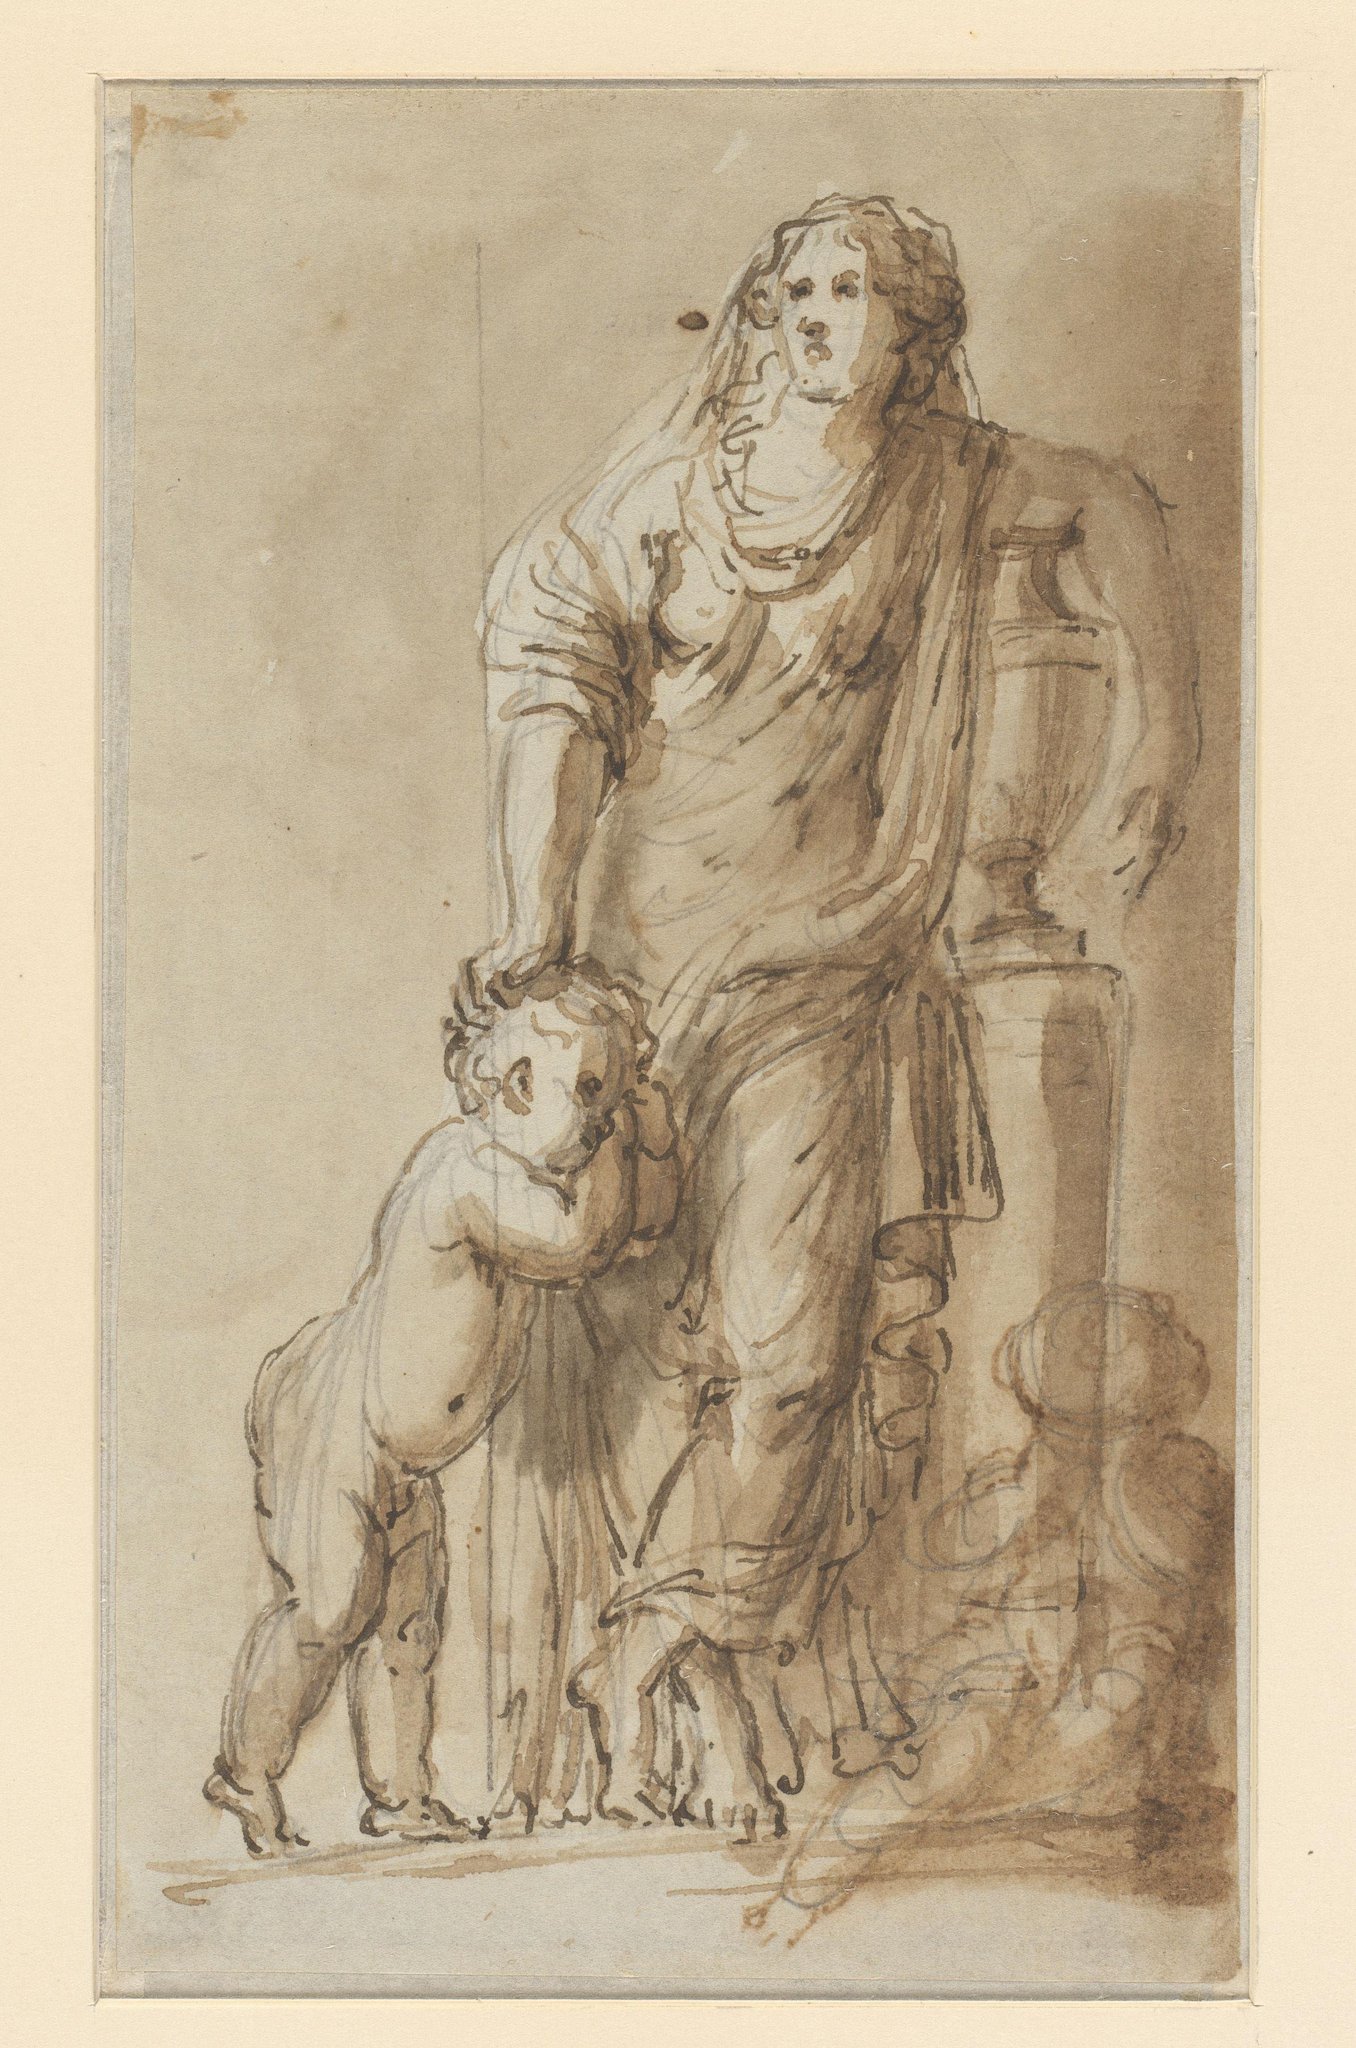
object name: drawing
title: Treurende vrouw met twee kinderen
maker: guillaume-jacques herreyns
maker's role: draughtsman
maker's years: 1743-1827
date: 1753-1827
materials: ink, paper, pencil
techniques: brush, pen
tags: mother and baby or young child, mourning the dead